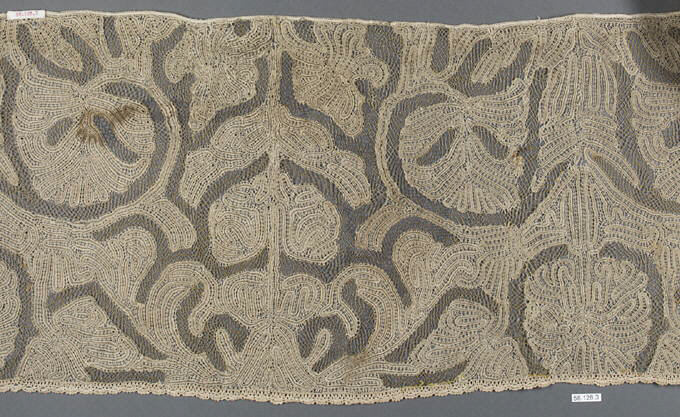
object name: border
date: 1801-1900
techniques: lace